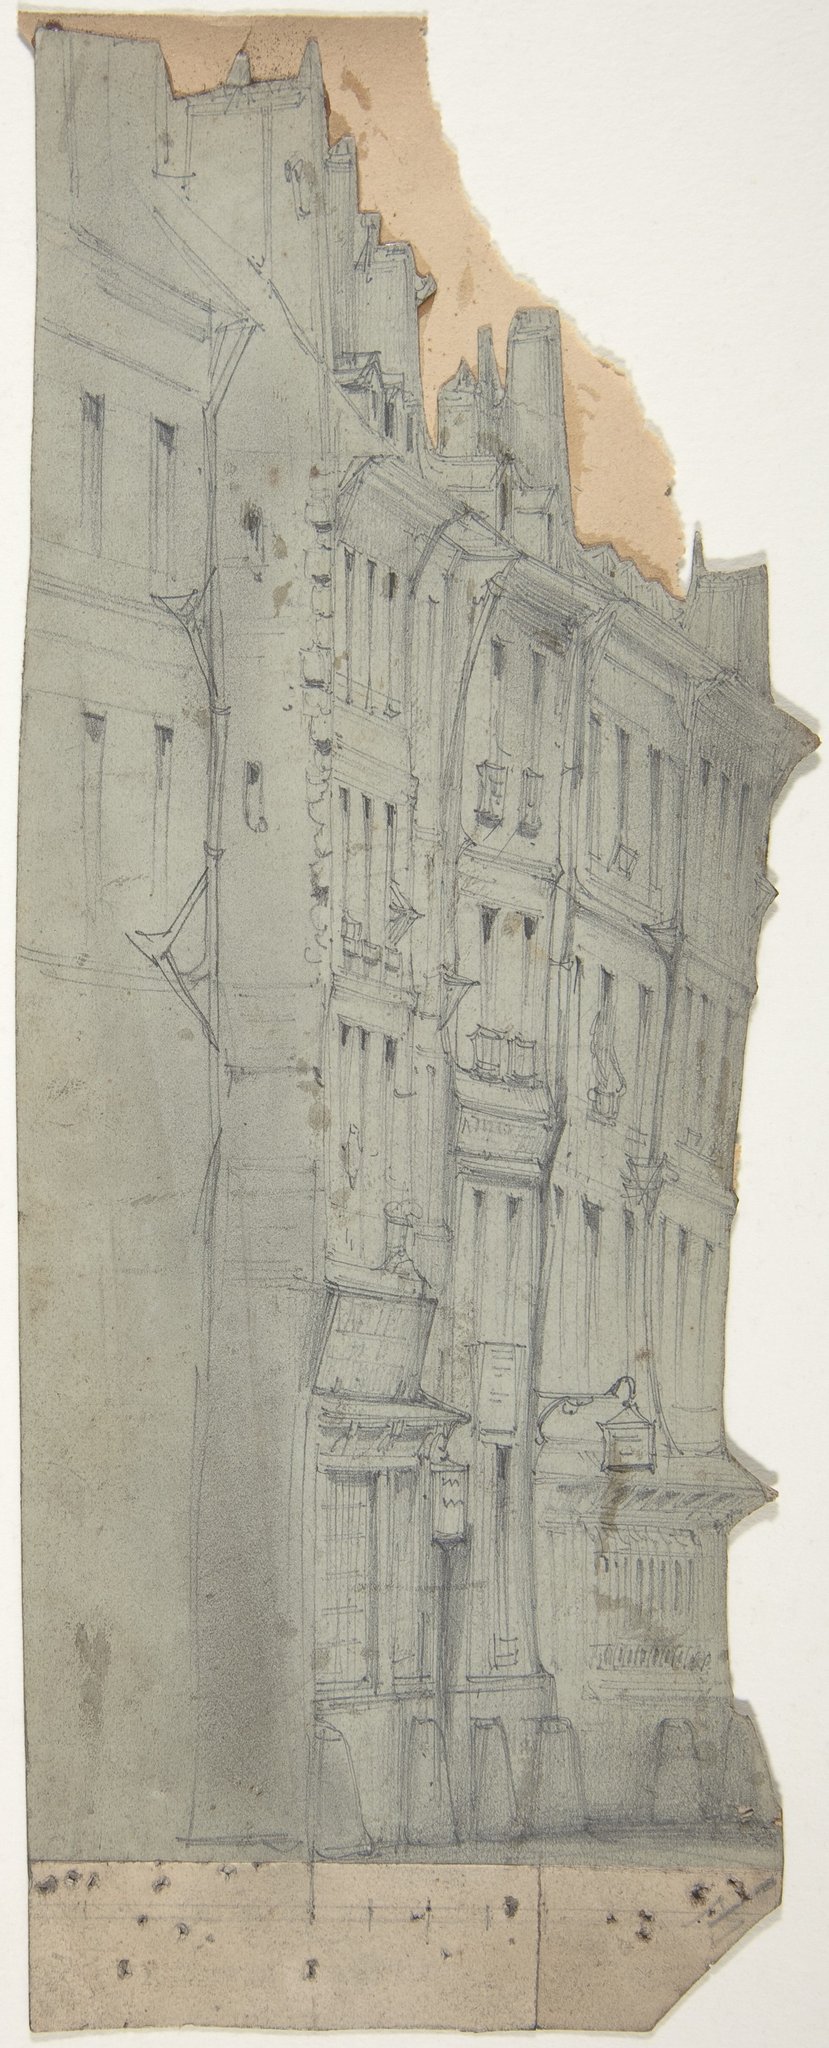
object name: drawing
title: Design for a Stage Set at the Opéra, Paris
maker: eugène cicéri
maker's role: artist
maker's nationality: french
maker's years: 1813-1890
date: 1830-1890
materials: graphite, paper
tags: buildings,stage design